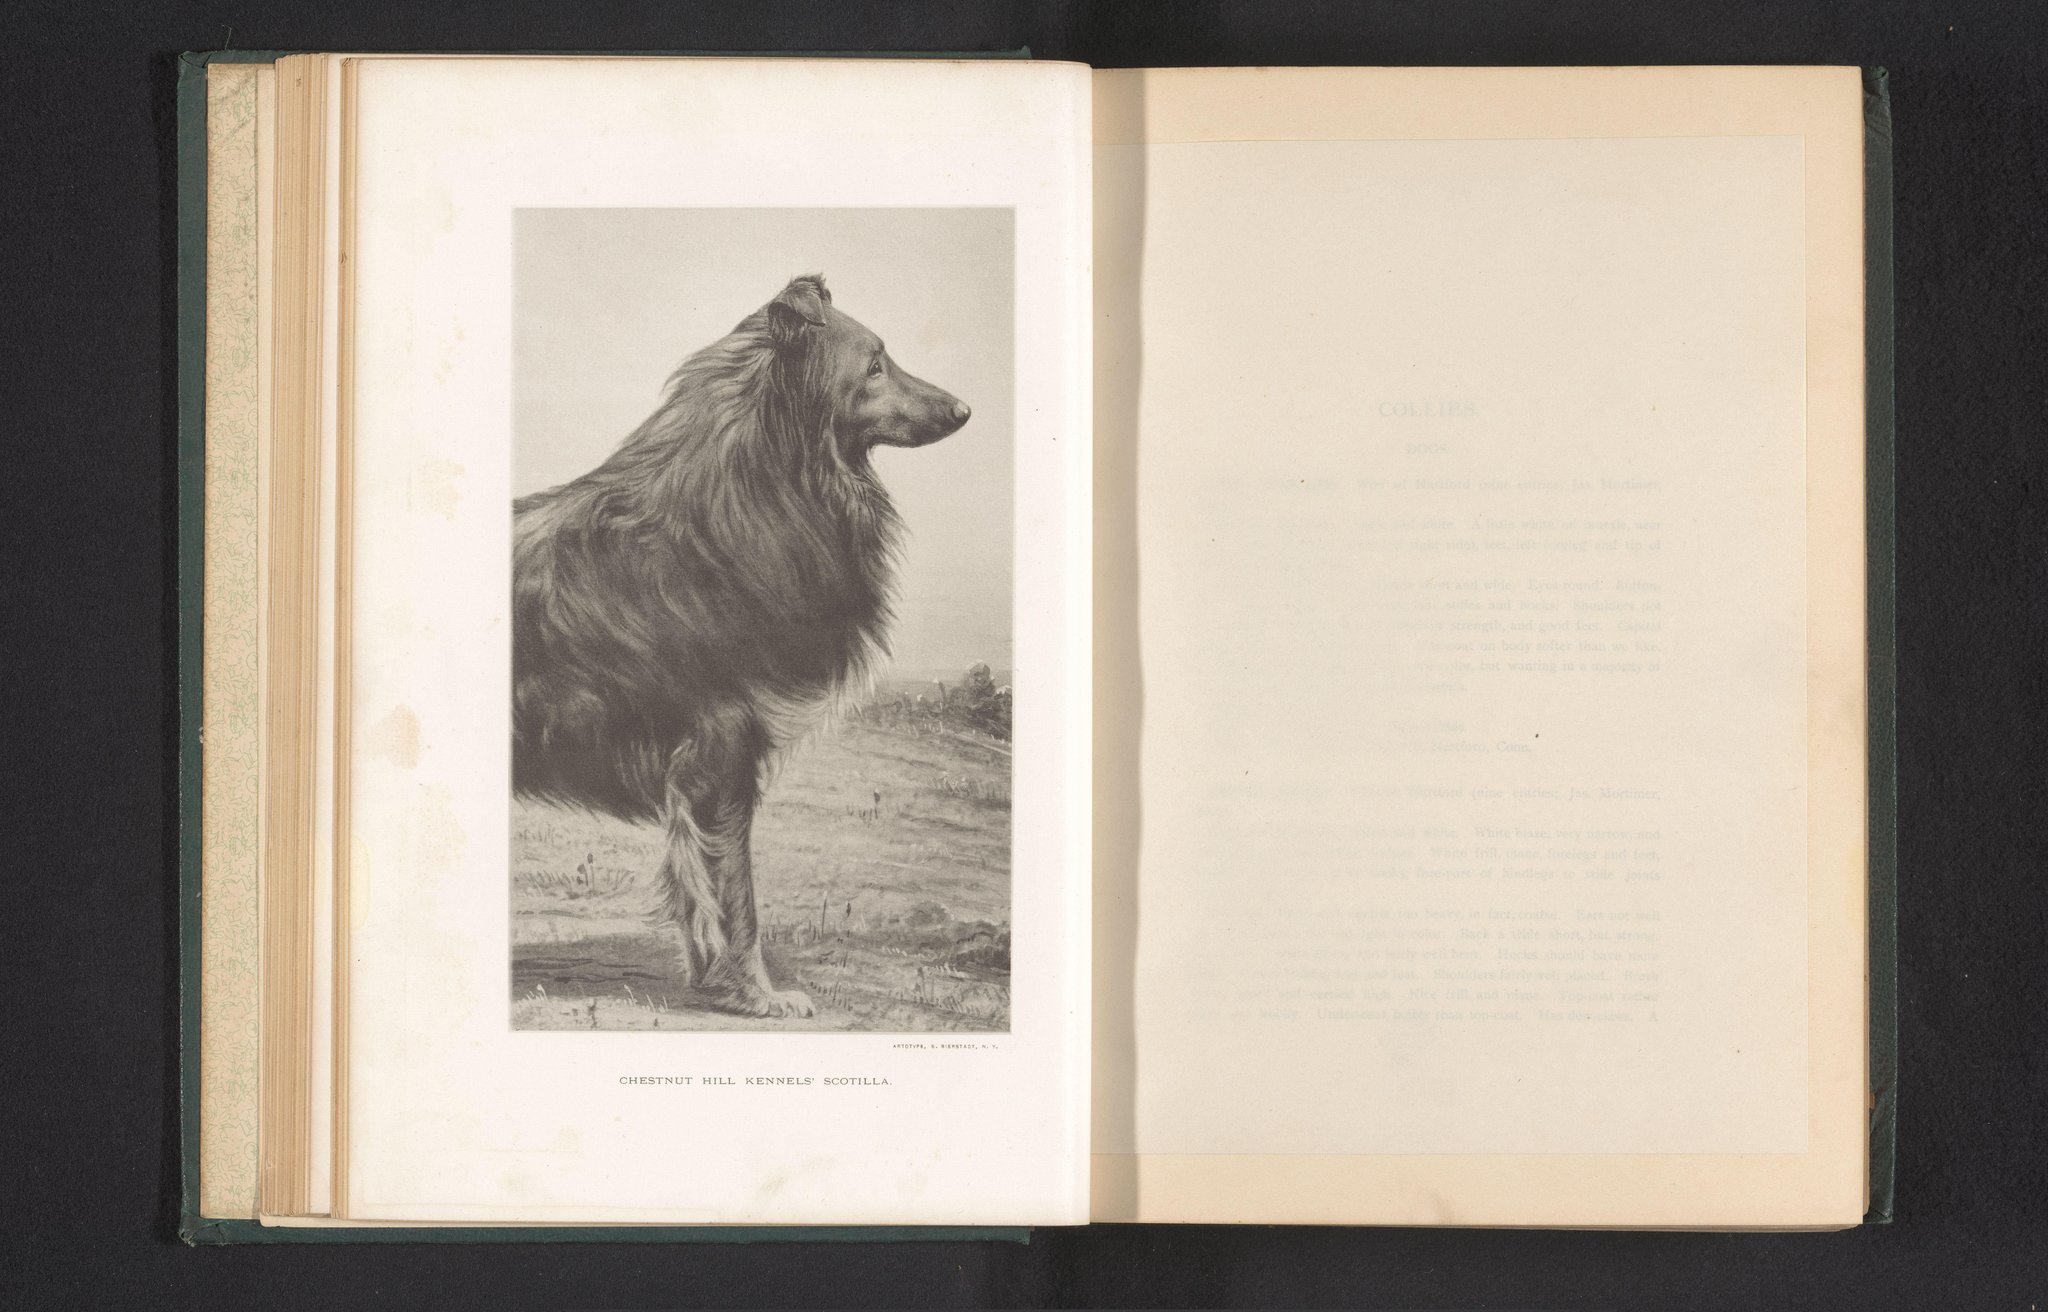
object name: page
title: Reproductie van een schilderij van een collie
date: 1883-1888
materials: paper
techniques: photograph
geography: new york city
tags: dog (with name of kind)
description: Prent tegenover pagina 51, achter semi-transparante omslag.